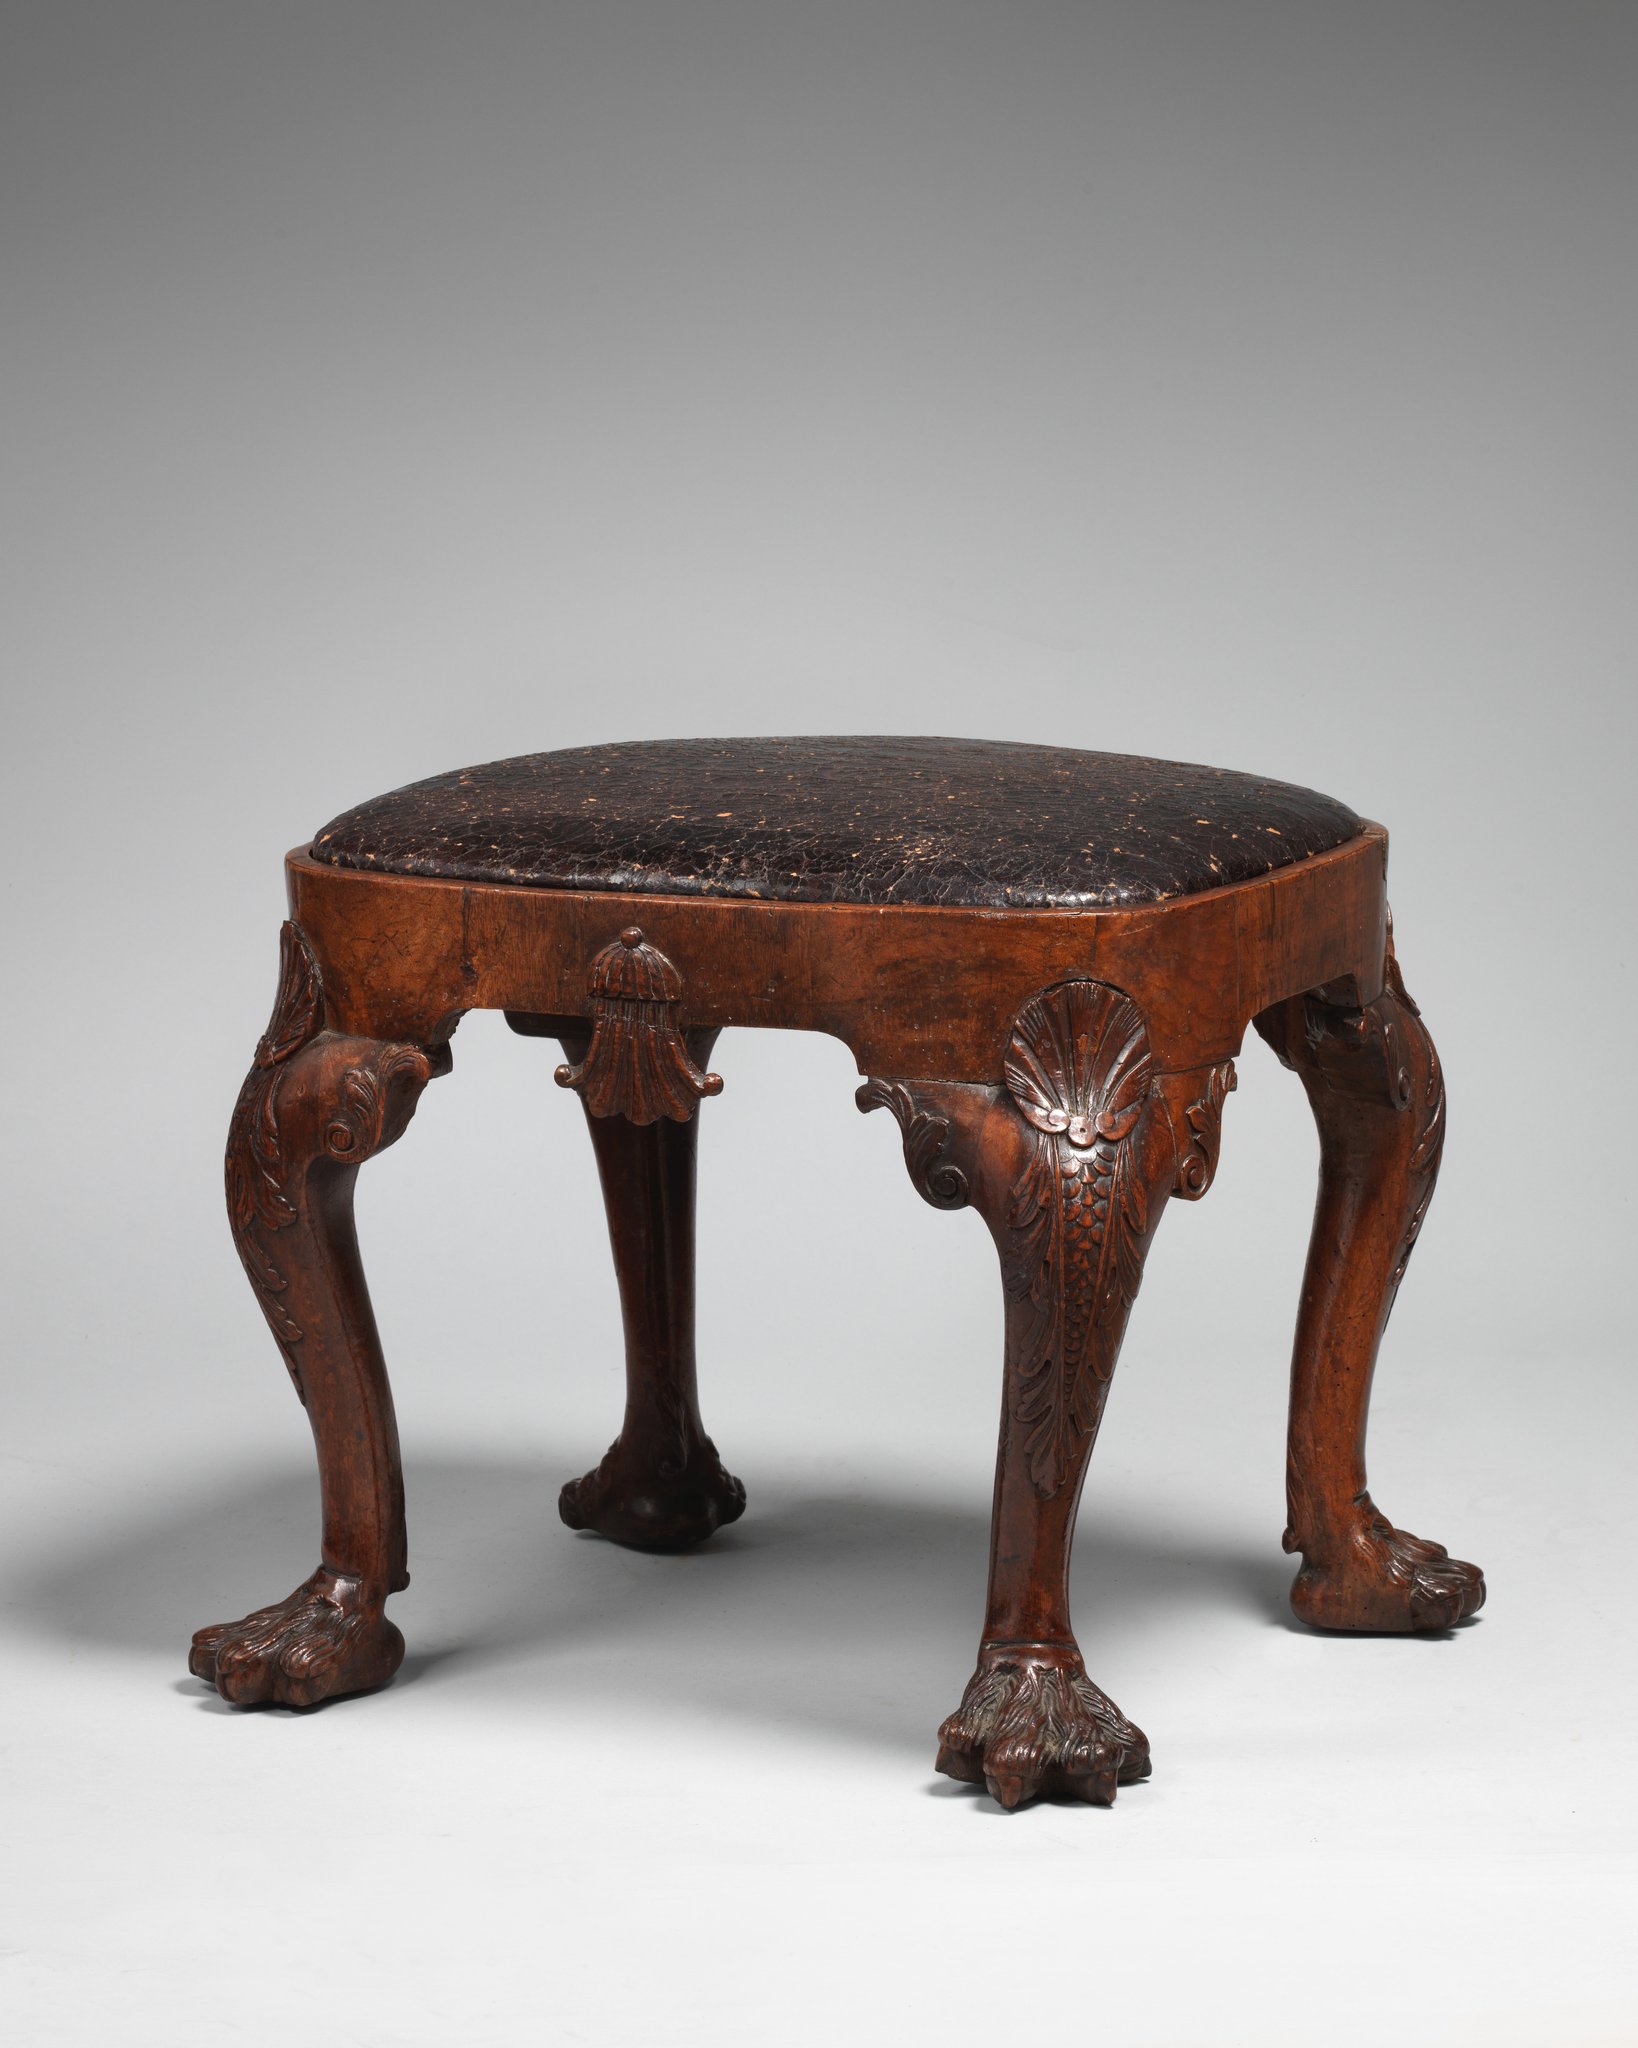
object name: stool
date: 1715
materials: wood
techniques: veneering